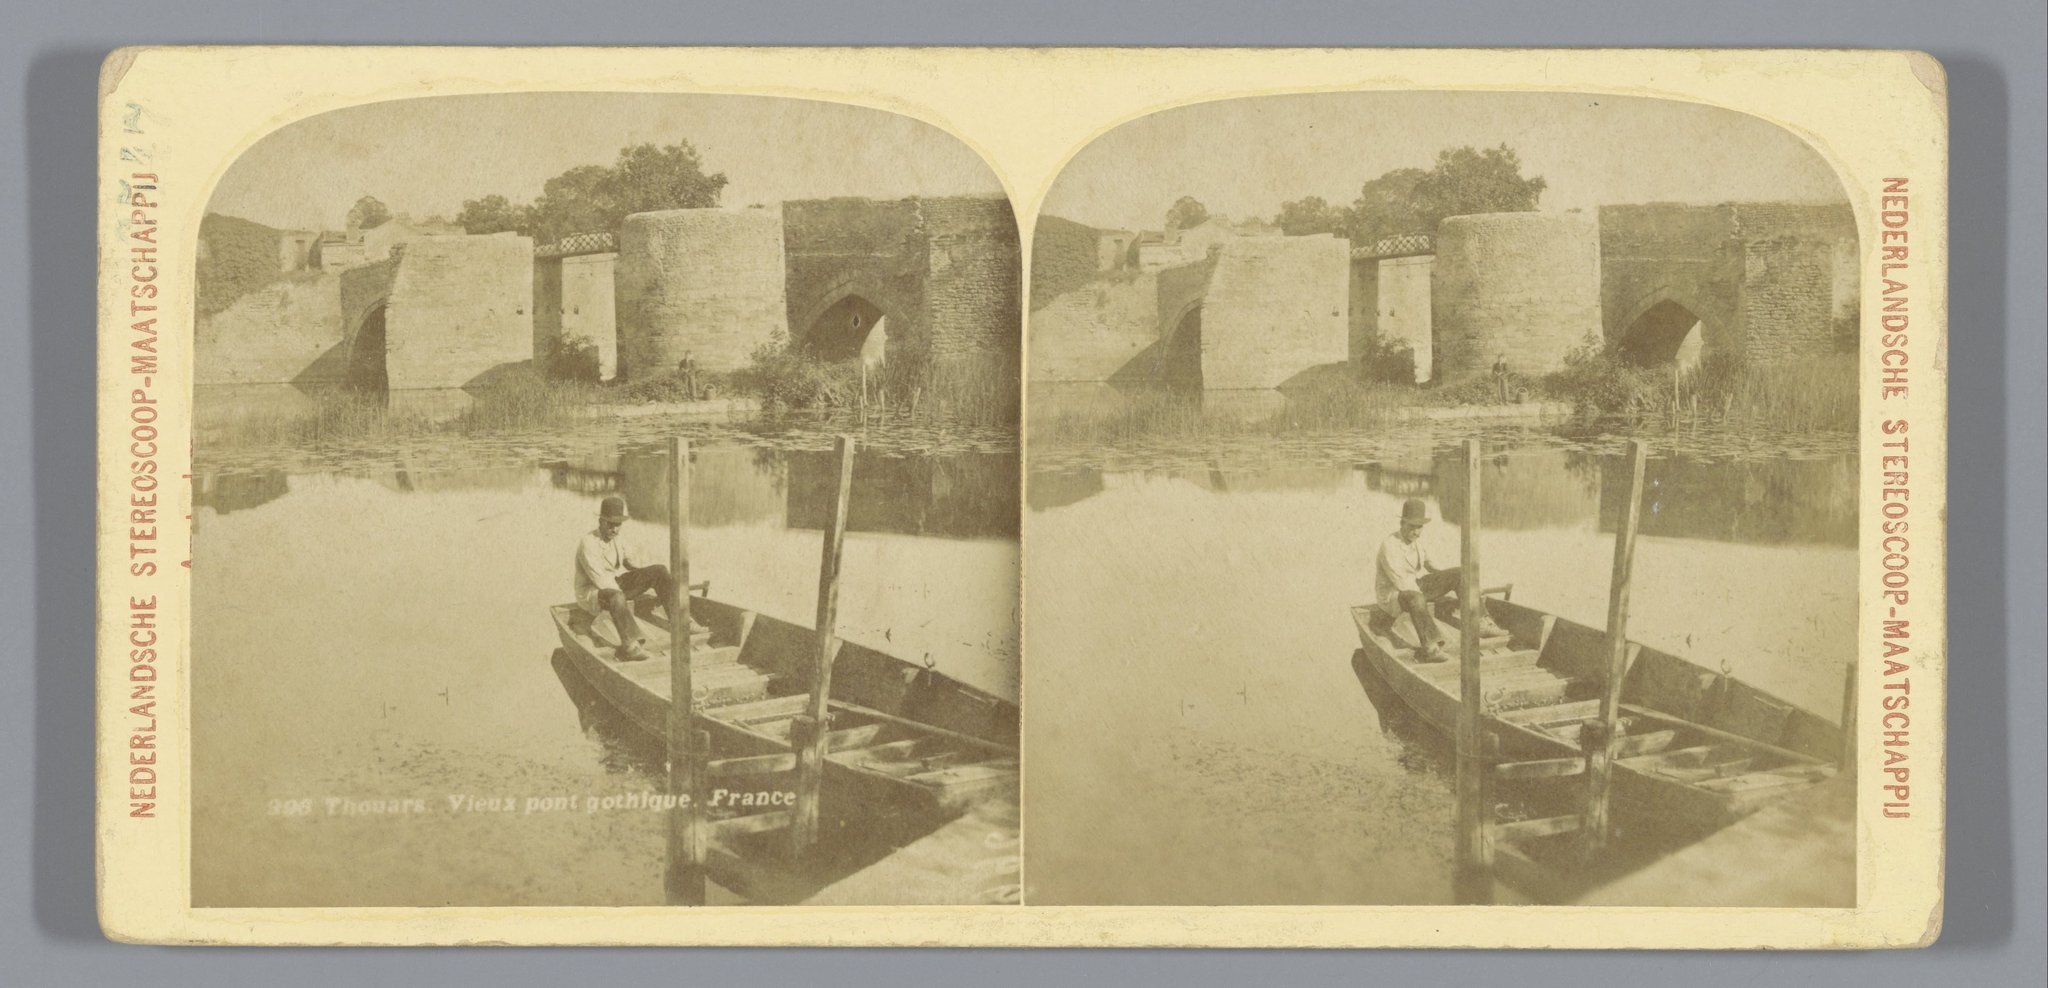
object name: stereograph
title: Gezicht op een brug en een man in een roeiboot bij Thouars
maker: j.g. beers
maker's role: fotograaf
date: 1850-1880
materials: cardboard, photographic support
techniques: albumen print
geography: thouars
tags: rowing-boat, canoe, etc., bridge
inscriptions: number: ‘[...]47’, number: ‘996’